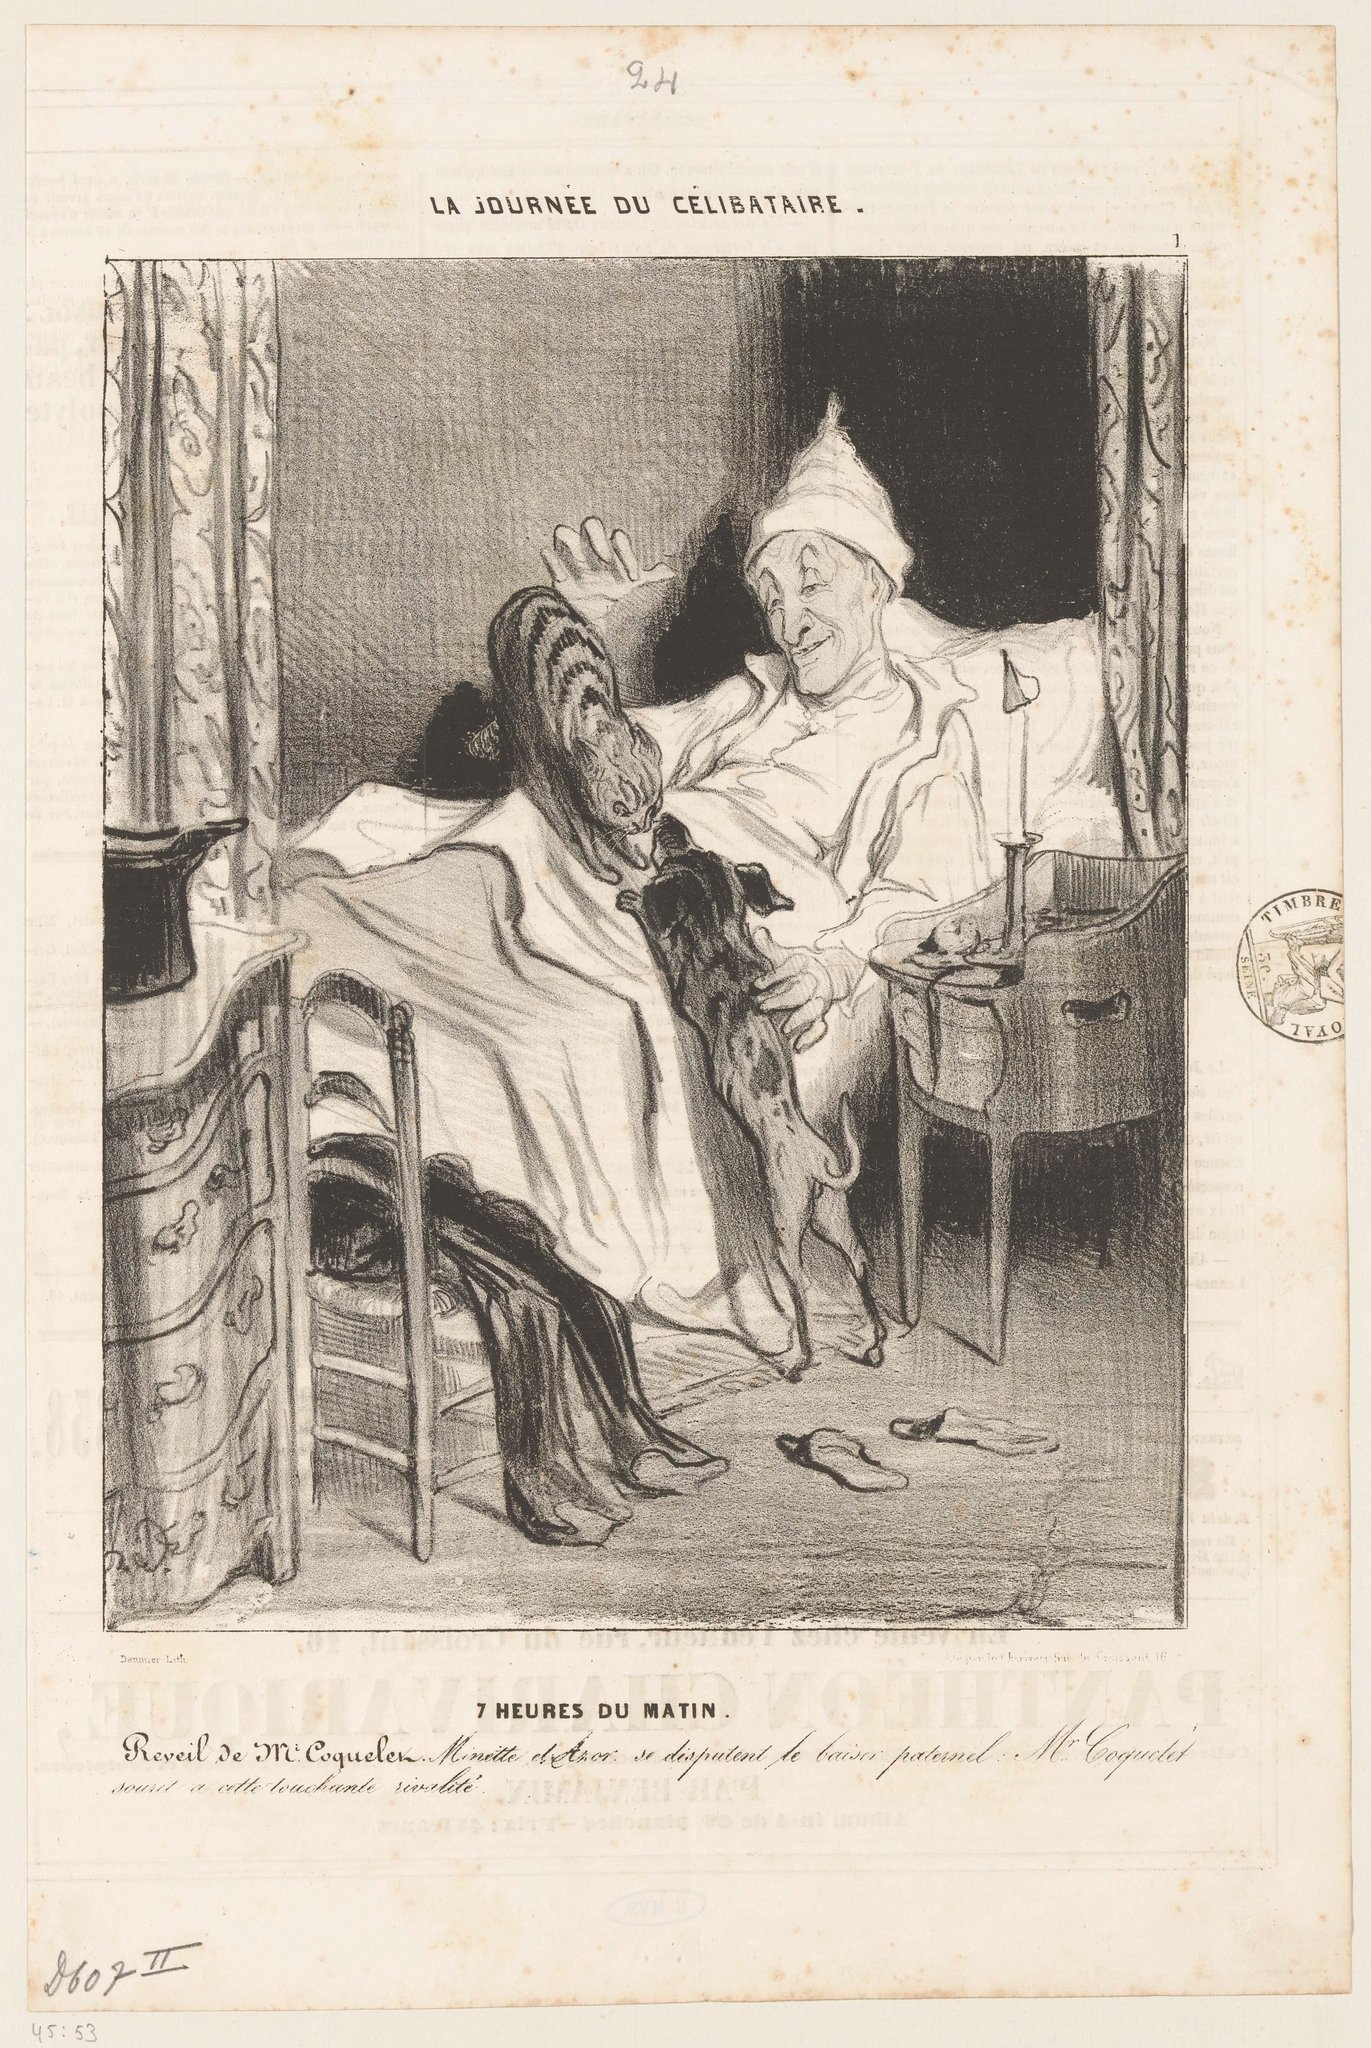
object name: cartoon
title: 7 Heures du matin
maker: honoré daumier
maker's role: draughtsman, painter, print maker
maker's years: 1808-1879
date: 1839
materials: paper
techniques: letterpress printing, lithograph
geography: paris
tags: caricatures (human types), single man, bachelor, waking up, friendship between man and animal; caressing, petting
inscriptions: collector's mark: Lugt 2228a, stamp: ‘Timbre Royal Seine, 3 c.’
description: Prent mogelijk uit: Le Charivari, 14 april 1839.